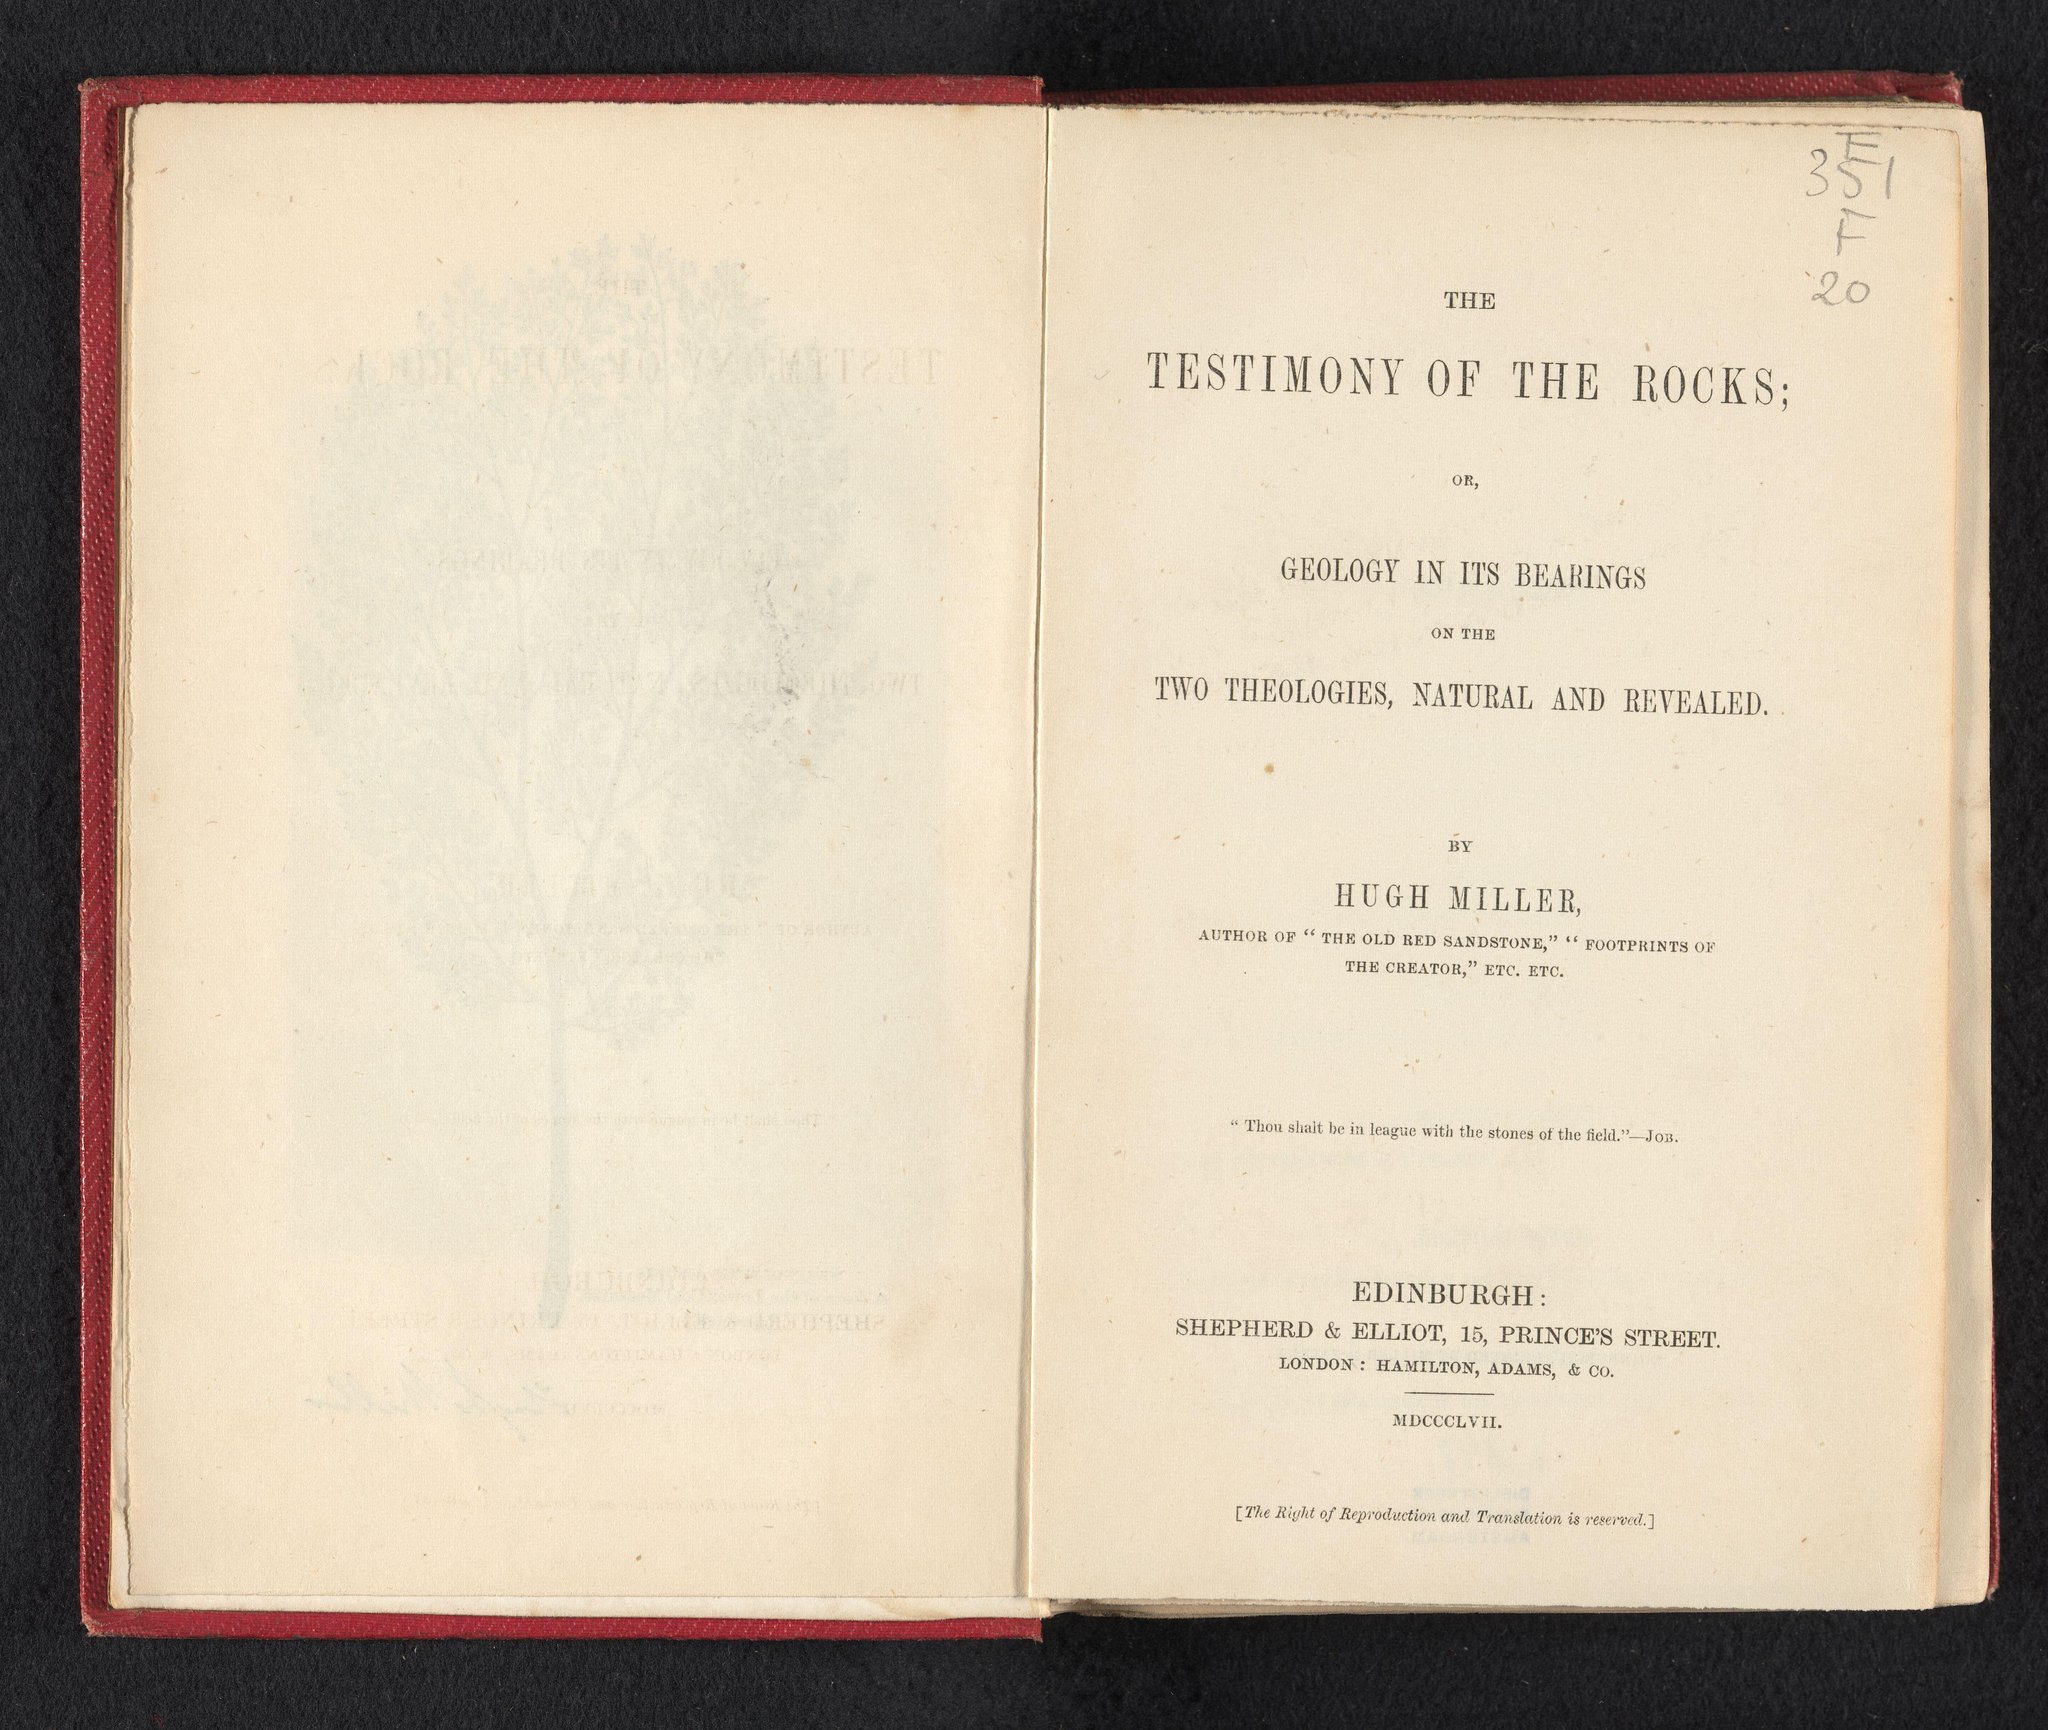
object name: book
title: The testimony of the rocks; or, geology in its bearings on the two theologies, natural and revealed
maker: hugh miller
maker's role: geoloog, schrijver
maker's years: 1802-1856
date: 1857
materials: cardboard, paper, linen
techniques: albumen print, letterpress printing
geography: edinburgh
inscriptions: collector's mark: ‘BIBLIOTHEEK/ RIJKSMUSEUM/ AMSTERDAM’, inscription: ‘N/ 5[?]7’, inscription: ‘6’, inscription: ‘HARRY WALKER,/ WESTWOOD NEWPORT.’, inscription: ‘1sv’